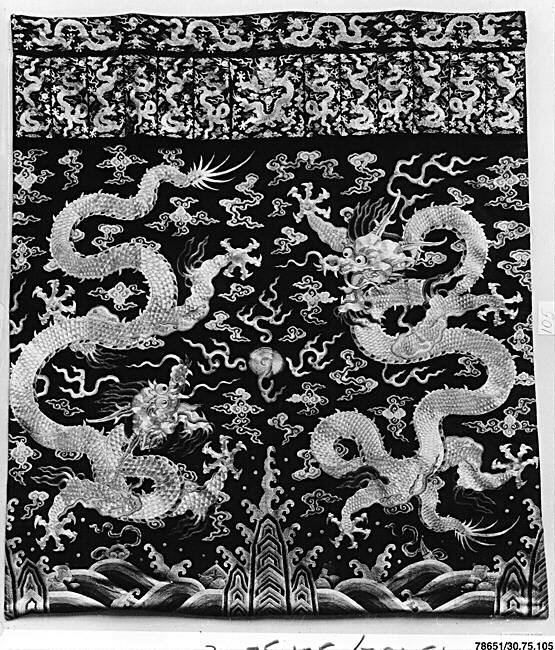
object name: hanging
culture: chinese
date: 1701-1800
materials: metal thread, silk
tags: dragons